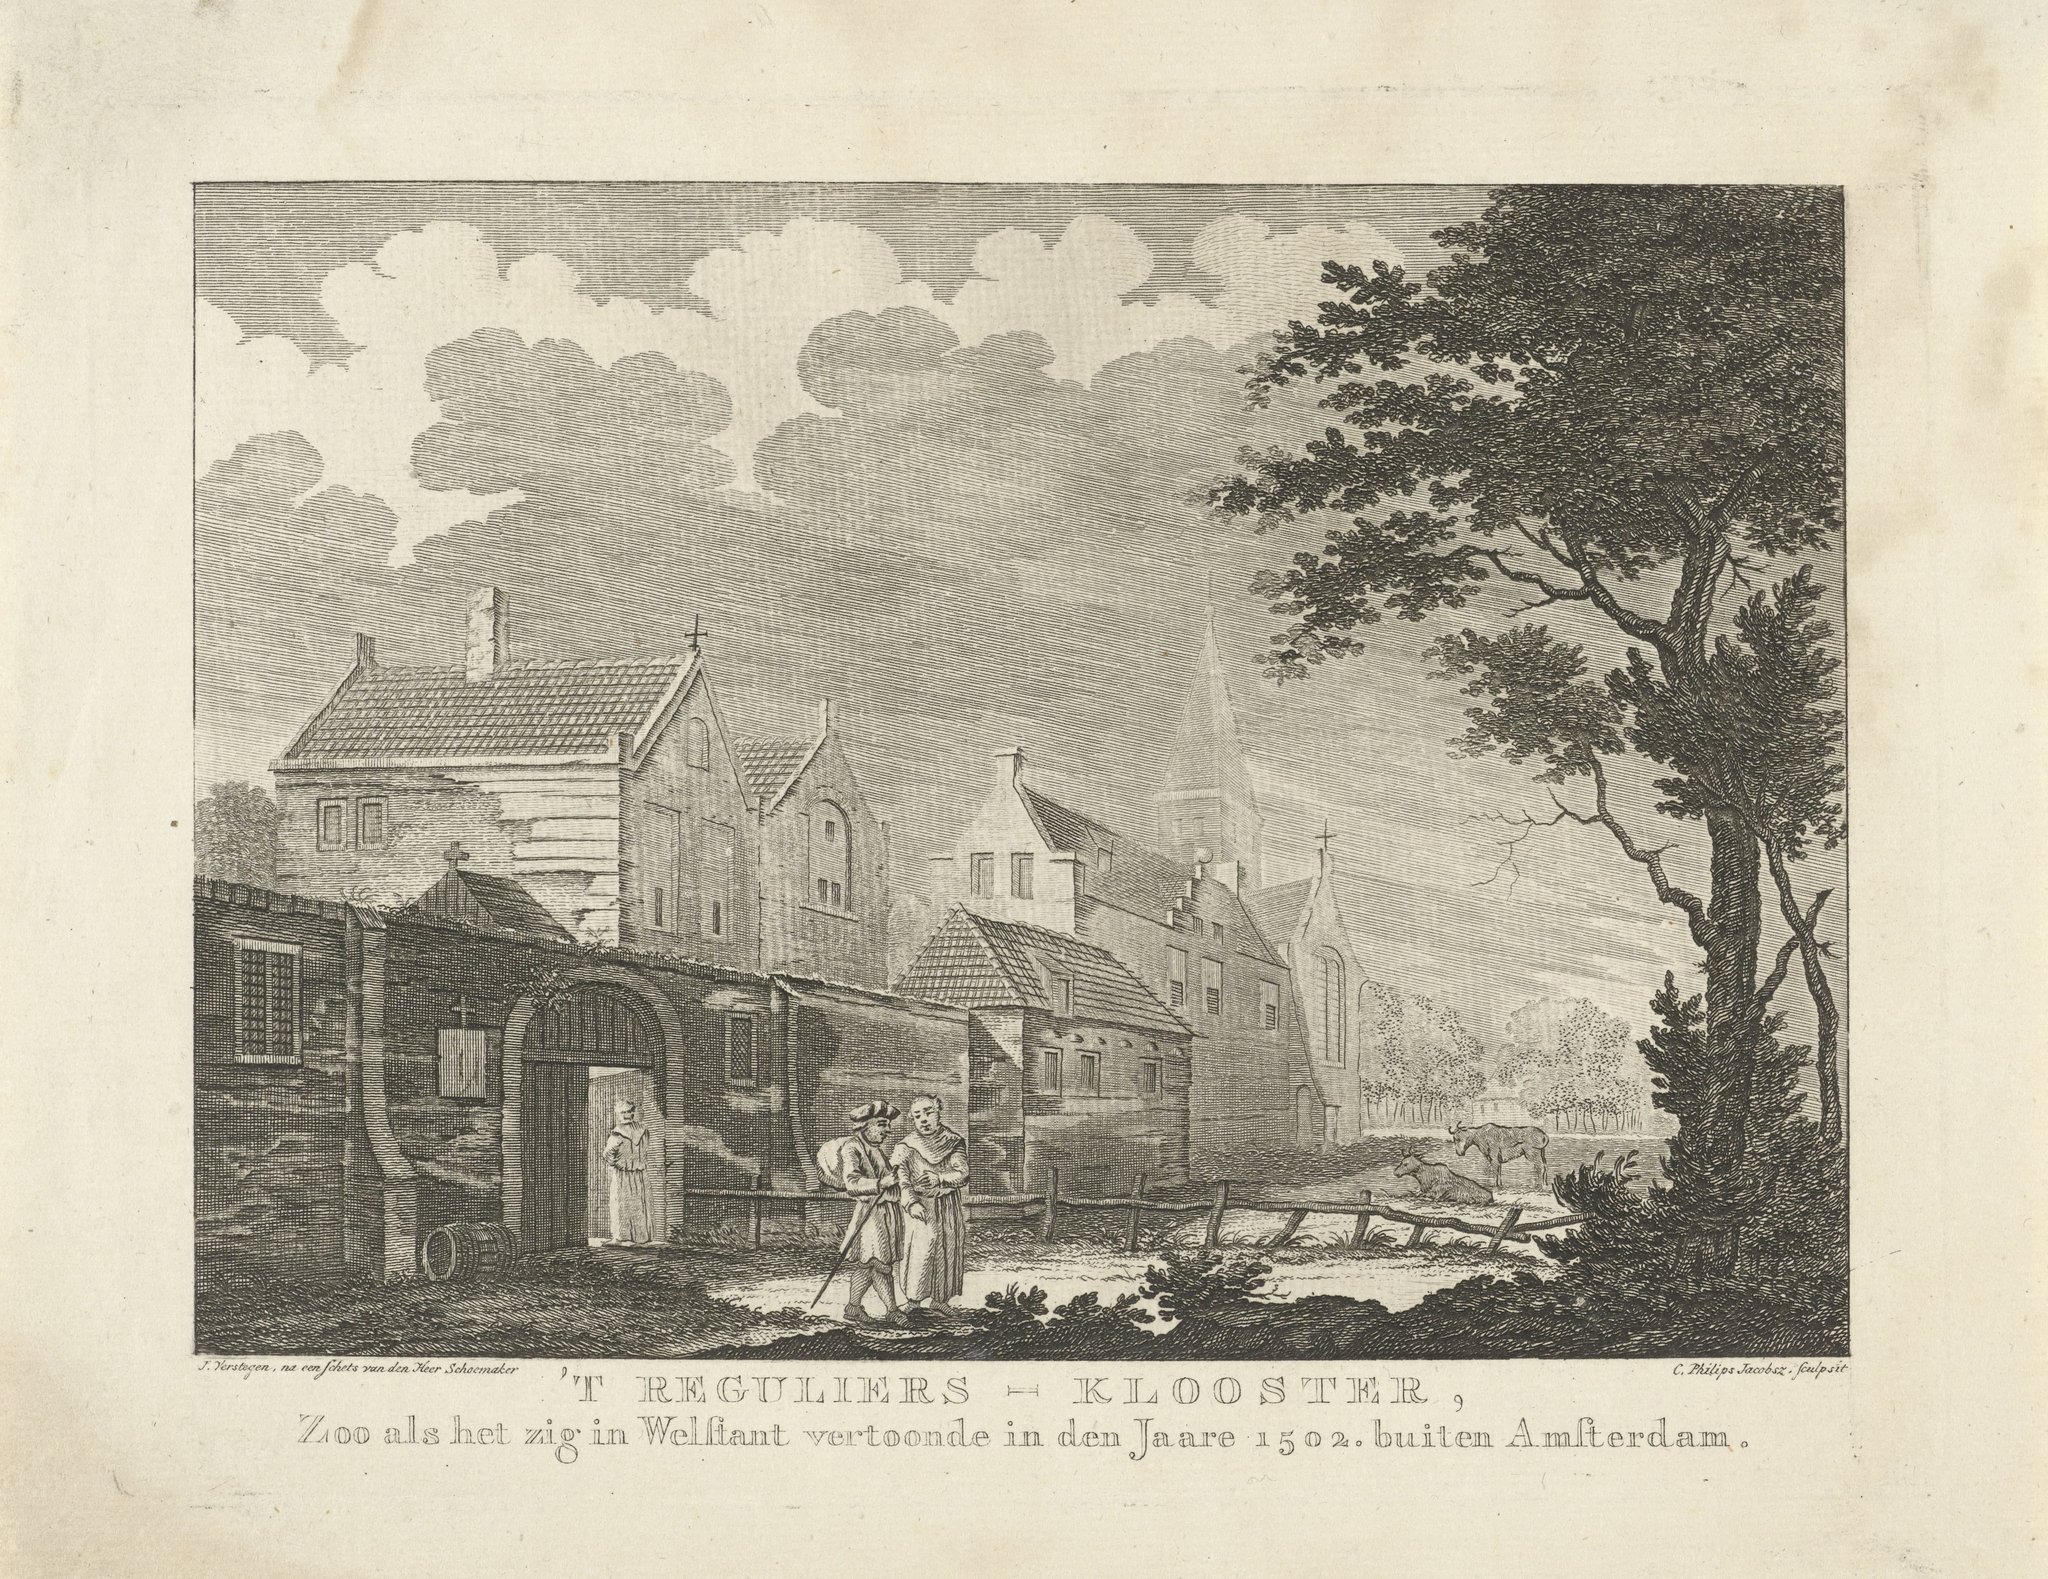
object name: print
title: 't Reguliers-Klooster, Zoo als het zig in Welstant vertoonde in den Jaare 1502. buiten Amsterdam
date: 1752-1789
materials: paper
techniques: engraving, etching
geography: amsterdam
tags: abbey, monastery, convent ~ roman catholic church, monk(s), friar(s)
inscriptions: collector's mark: Lugt 2228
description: Deze prent is ook ingebonden in enkele exemplaren van: Wagenaar, Jan. Amsterdam, in zyne opkomst, aanwas, geschiedenissen (…). 3 delen [folio-uitgave]. Amsterdam: Isaak Tirion en Yntema & Tieboel, 1760-1767, dl. 2 (Isaak Tirion, 1765). Komt echter niet voor in de lijst met in te binden prenten van deze uitgave (te vinden in dl. 3) - en is er dus ook niet voor bedoeld.